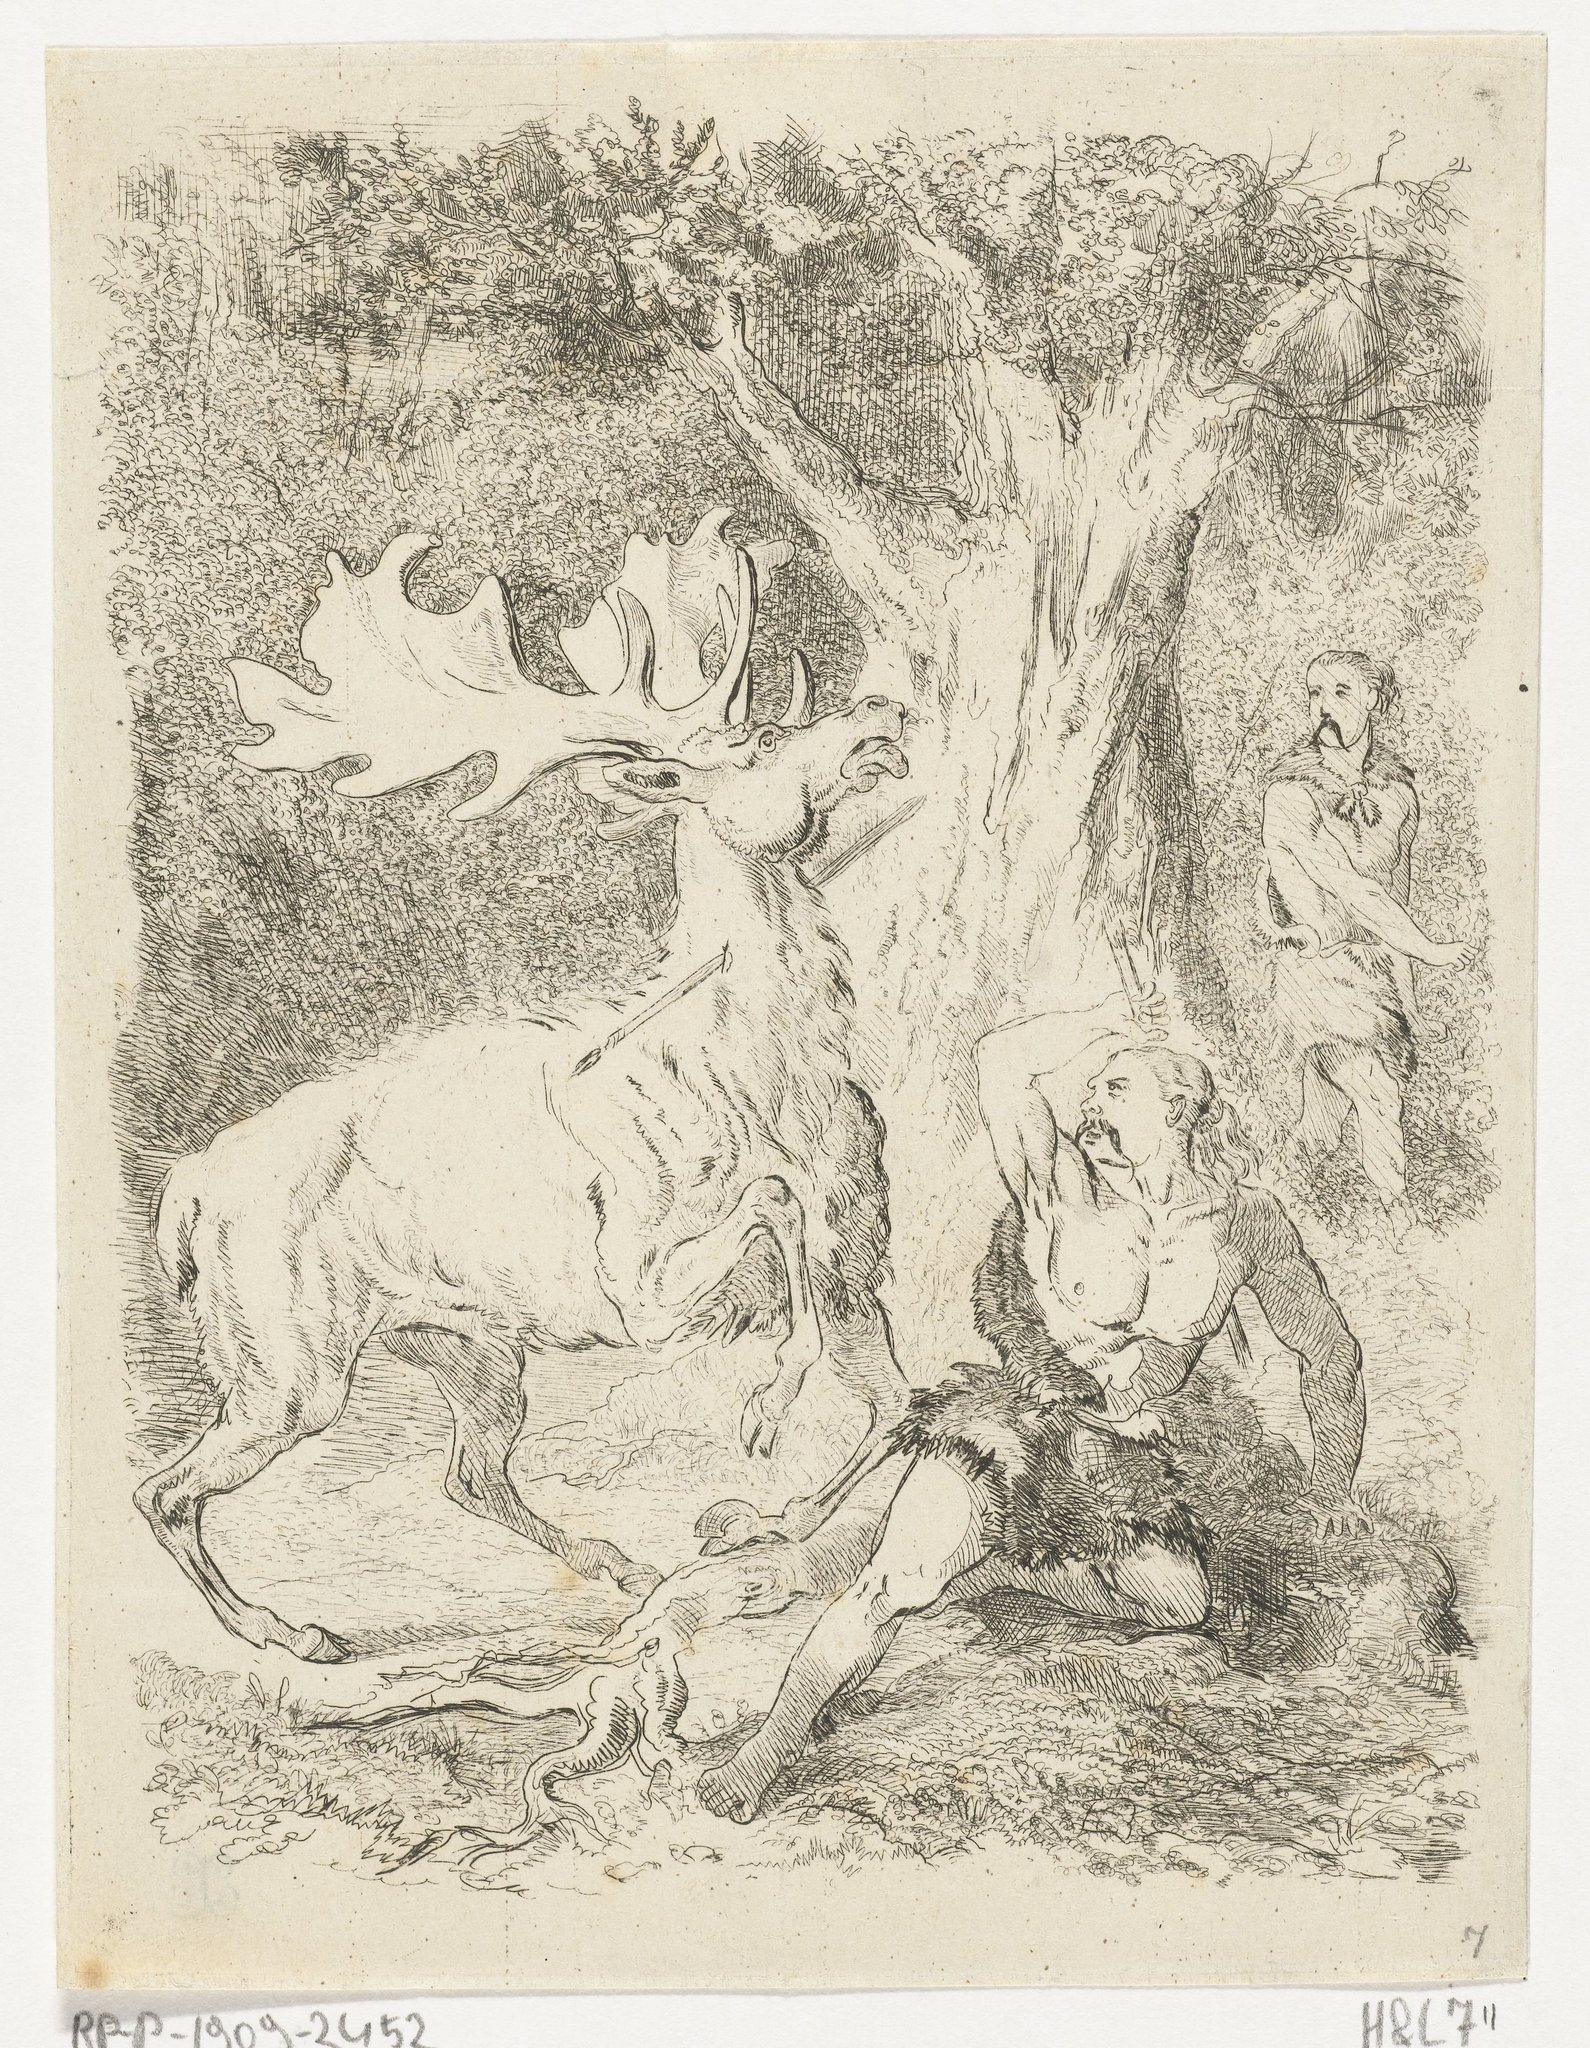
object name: print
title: Aeddon redt het leven van Kaibar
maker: karel frederik bombled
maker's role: draughtsman, print maker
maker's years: 1822-1902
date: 1852-1902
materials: paper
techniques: drypoint, etching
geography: delft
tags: hunters hunting (n.b.: in 1988-1990 this notation denoted the concept of 43c11421 'hunters resting during the hunt'), hunt ~ hoofed animals, tales and fairy tales (aeddon), extinct, 'historical' peoples: gauls (+ women)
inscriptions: collector's mark: Lugt 2228, collector's mark: Lugt 1485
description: Een eland staat op het punt een Keltische jager (Kaibar) te doden. Aeddon, verscholen in de struiken rechts, belet dit door met een werpspeer de hals van het dier te doorboren. Illustratie bij de tweede zang van het episch lofgedicht Aeddon